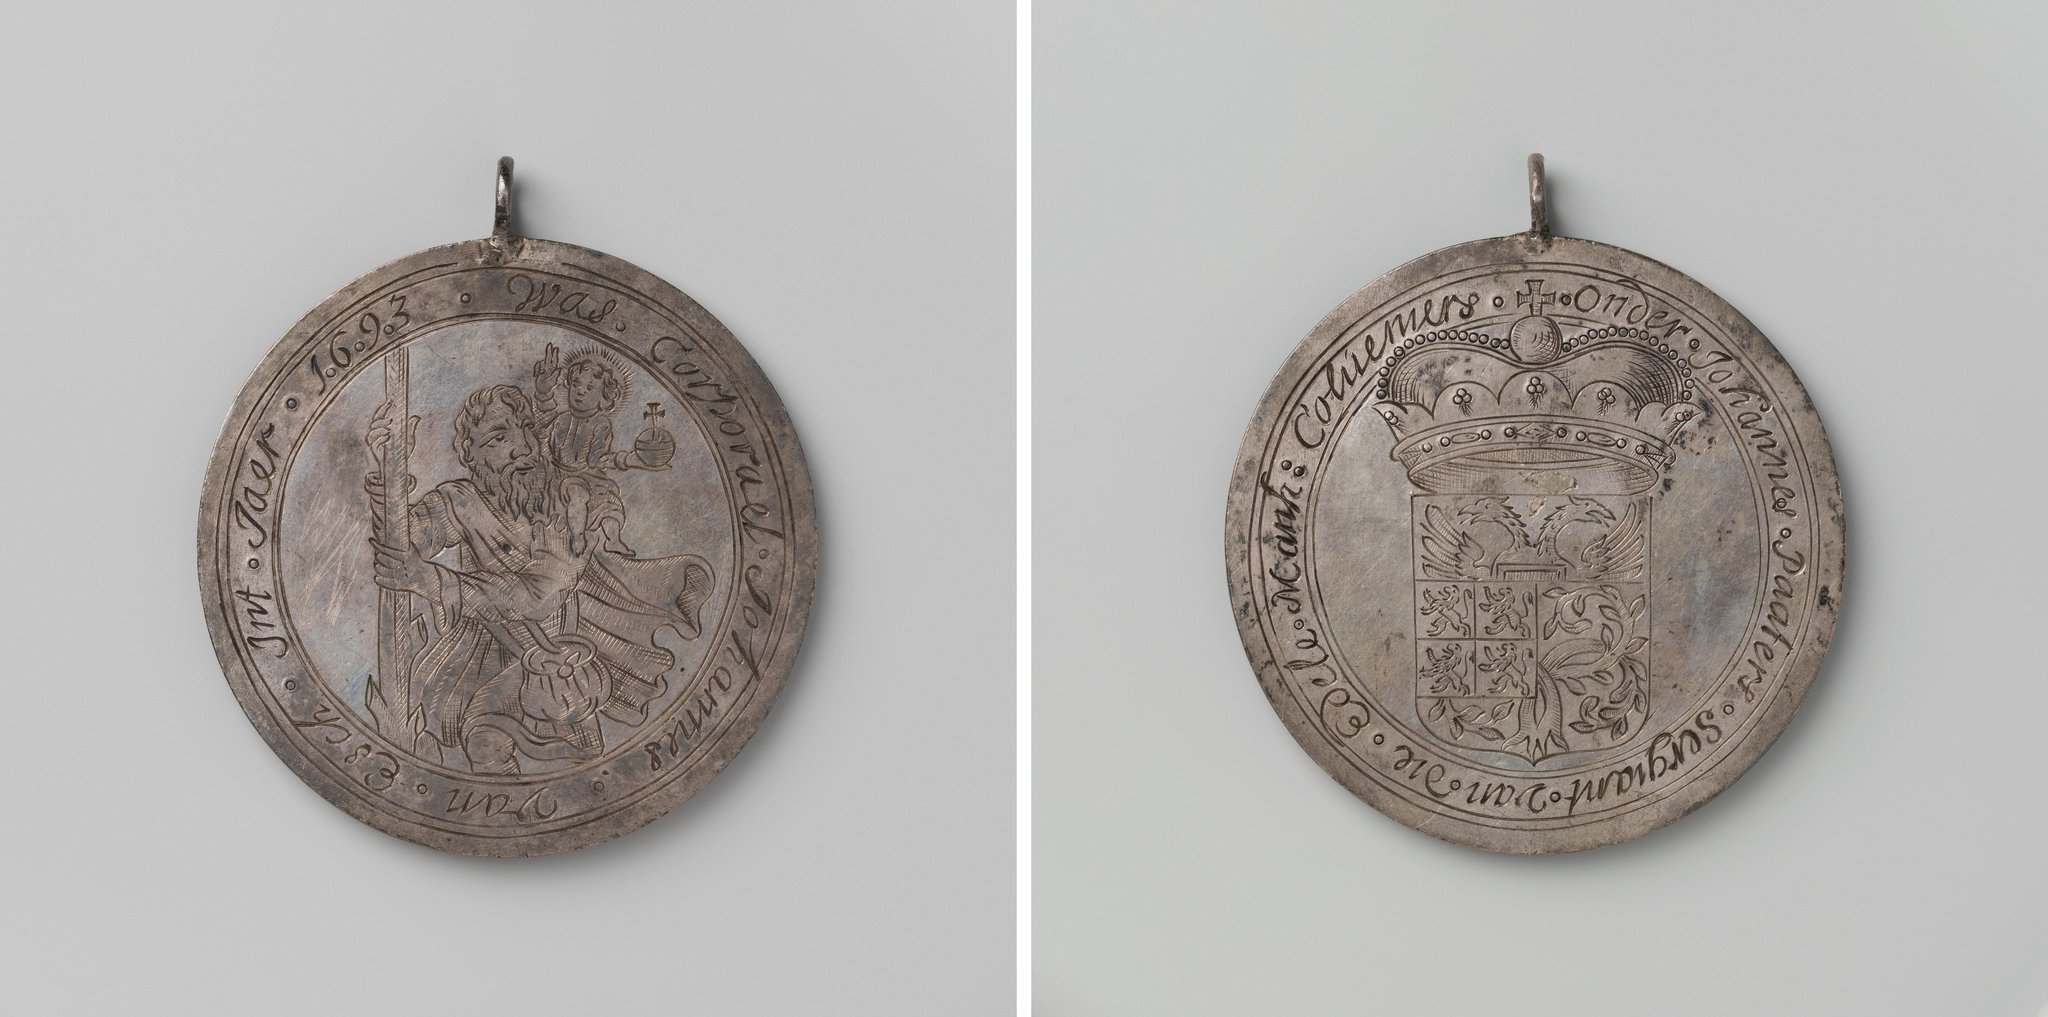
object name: marksman medal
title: Schutterij van de Edele Manhafte Colveniers te 's-Hertogenbosch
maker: Anonymous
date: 1693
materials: silver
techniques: engraving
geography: den bosch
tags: den bosch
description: Zilveren penning aan draagoog. Voorzijde: Christophoor met beidehanden paal omklemmend, draagt op schouder Christus-kind dat in linkerhand wereldbol draagt en met rechterhand zegent binnen omschrift. Keerzijde: gekroond wapenschild binnen omschrift